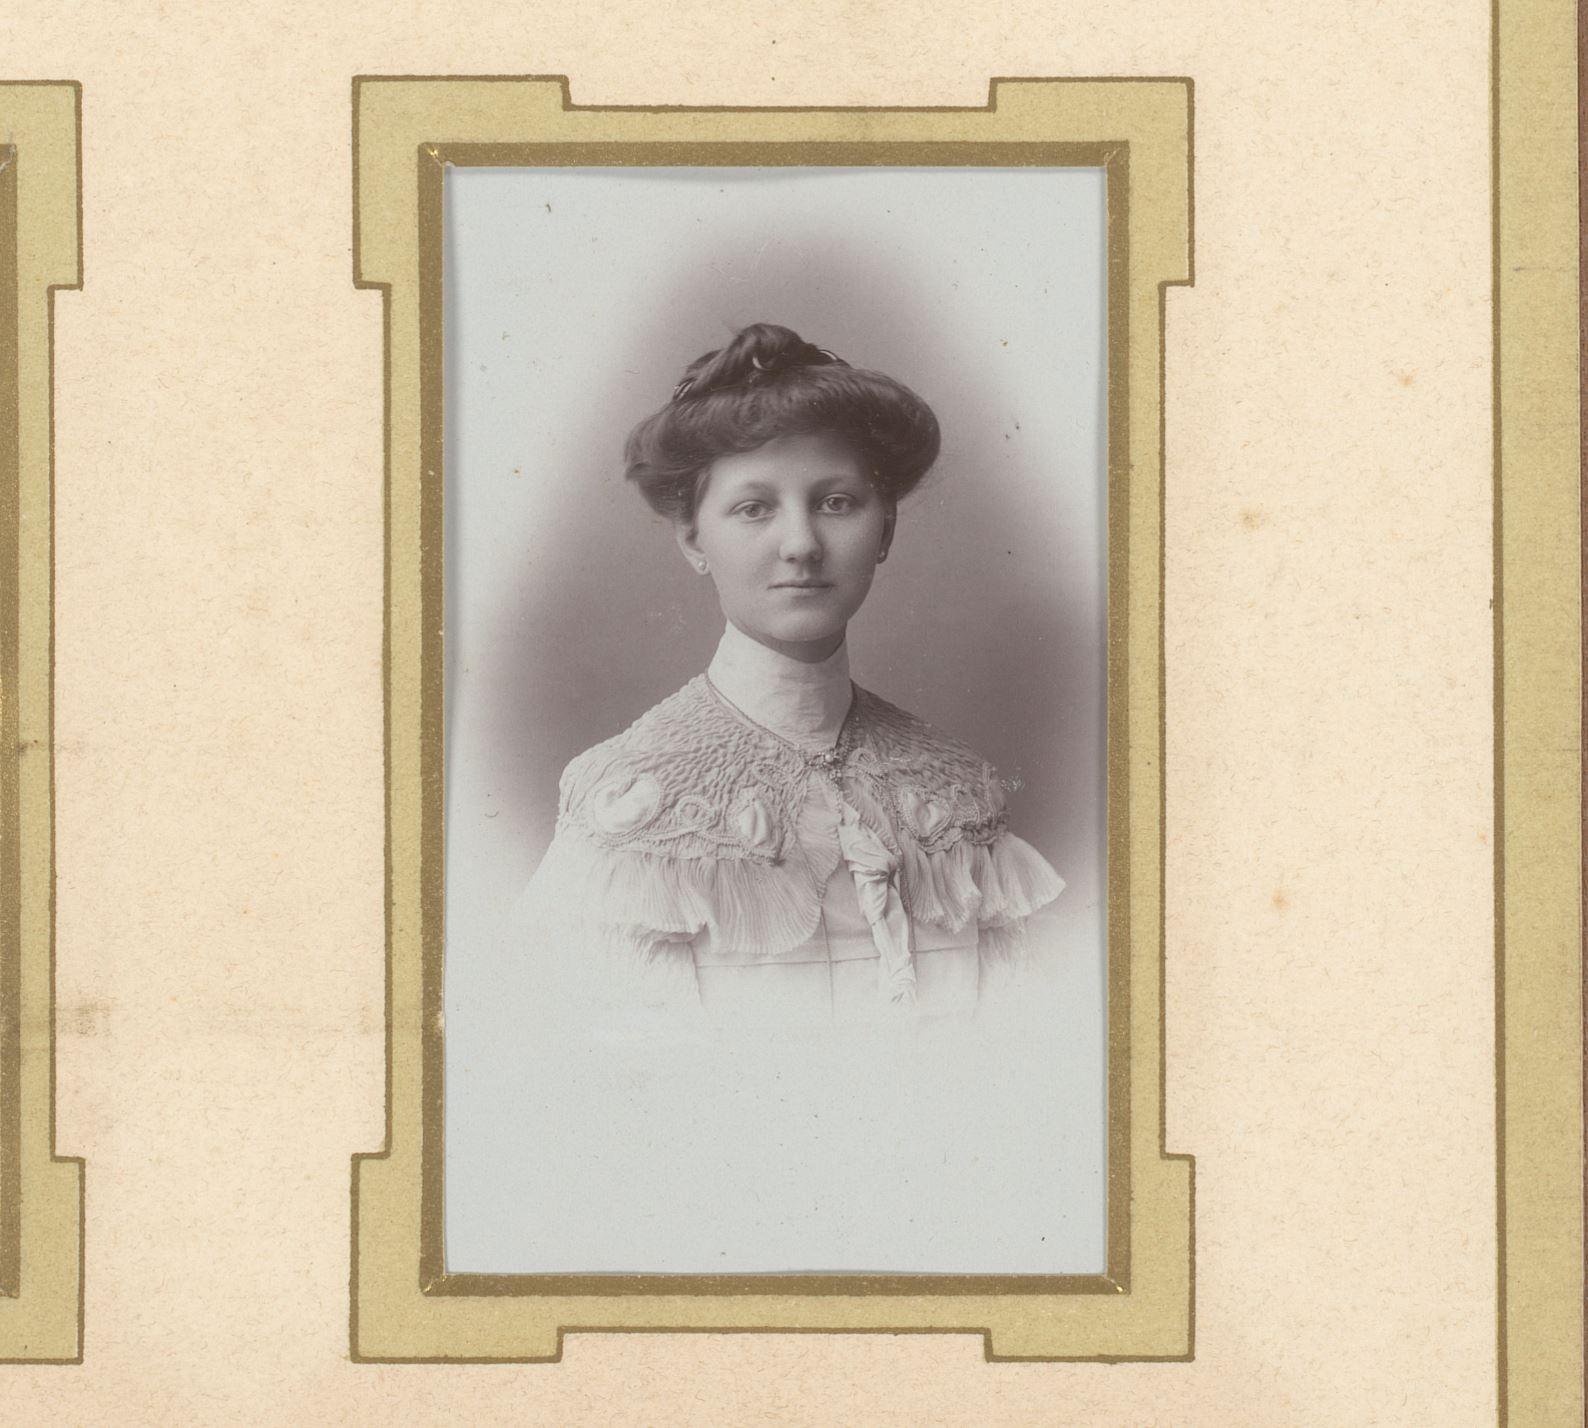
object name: photograph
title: Portret van een meisje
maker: emile morren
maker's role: fotograaf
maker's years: 1865-1941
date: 1860-1900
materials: cardboard, photographic support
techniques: collodion silver print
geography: leuven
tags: girl (child between toddler and youth)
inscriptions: inscription: ‘Emile Morren (...) 18 Rue de Namur/ Louvain’